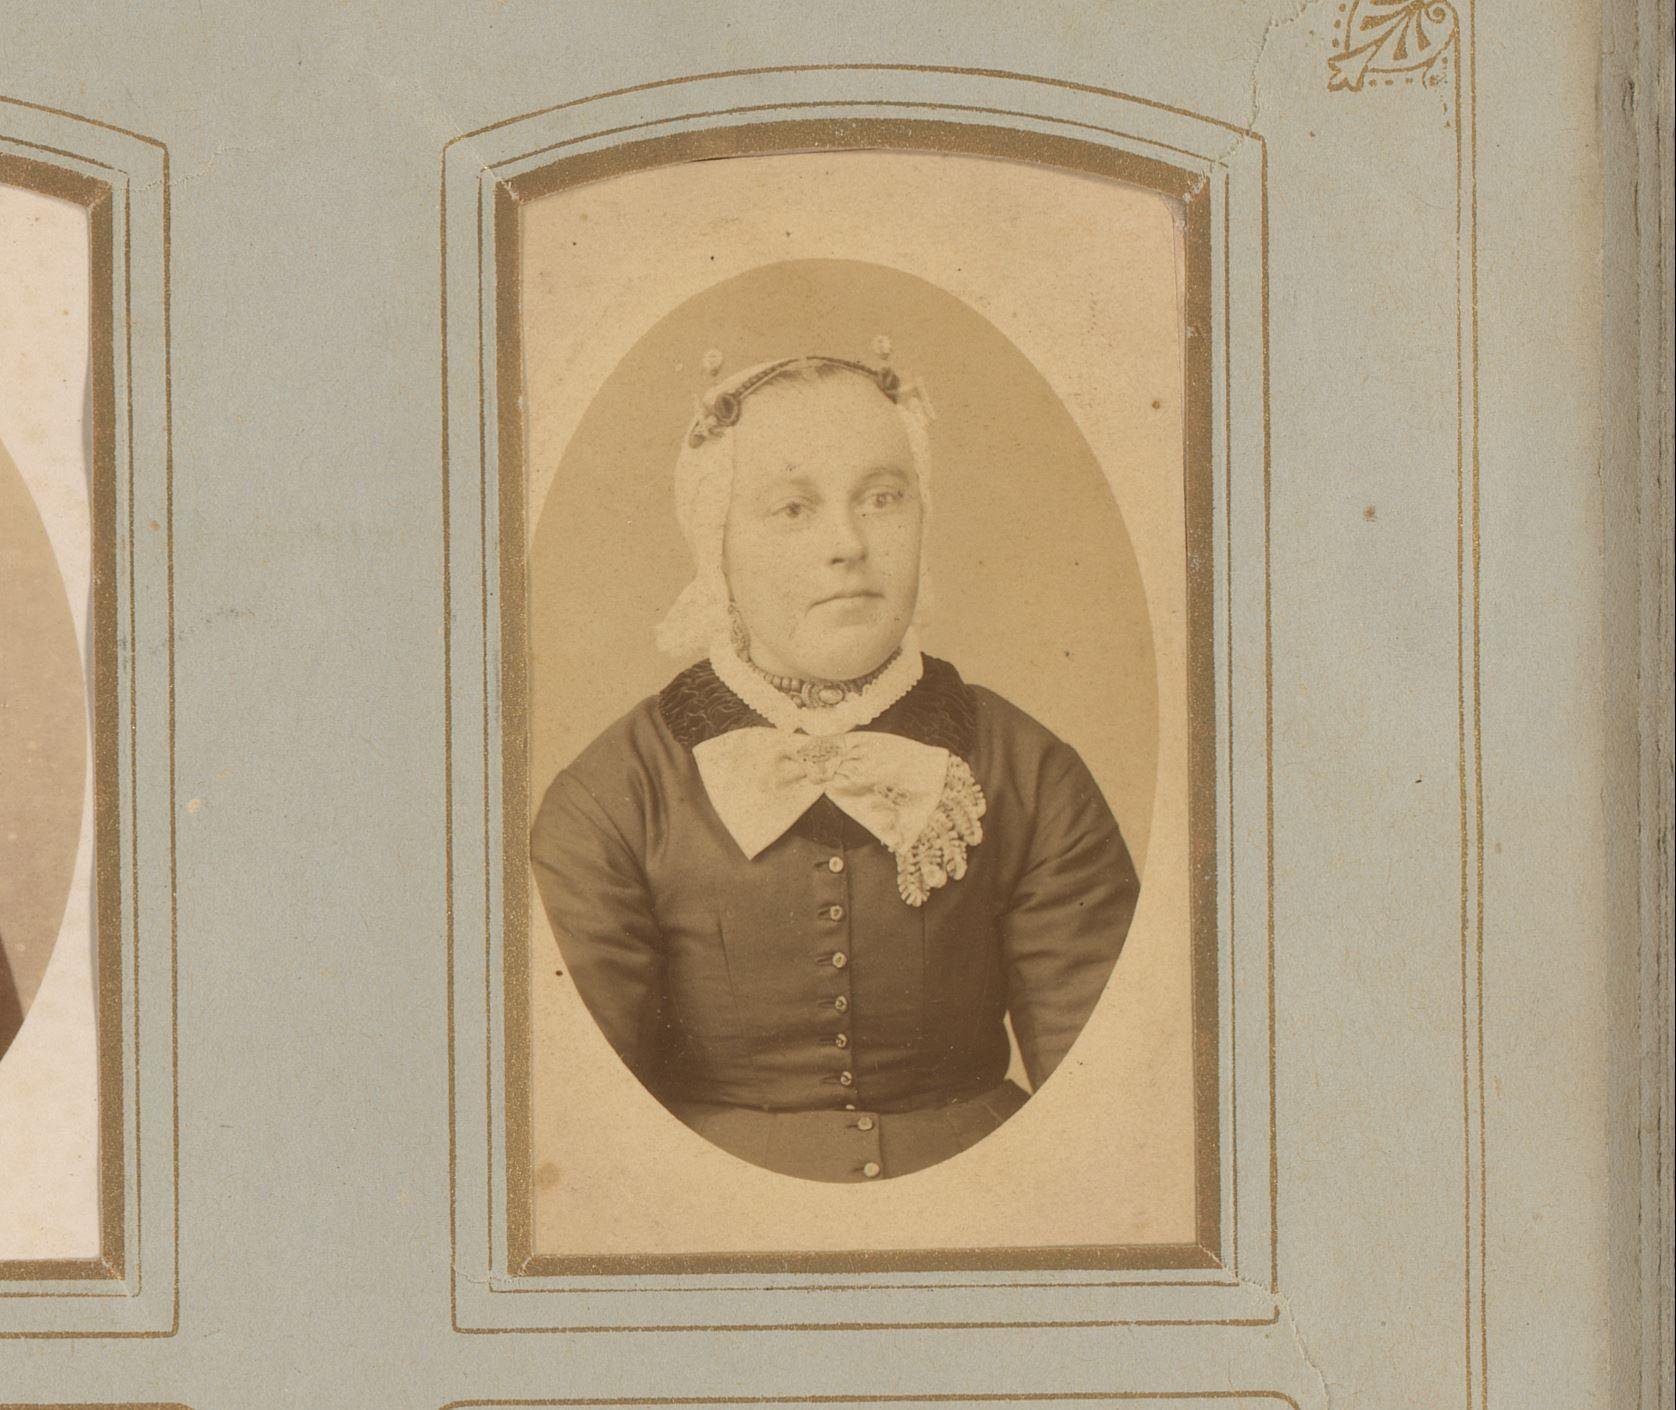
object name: album leaf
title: Portret van een vrouw met klederdrachtmuts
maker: Anonymous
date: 1850-1900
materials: cardboard, photographic support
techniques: albumen print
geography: netherlands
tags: historical persons - bb - woman, head-gear: cap, folk costume, regional costume